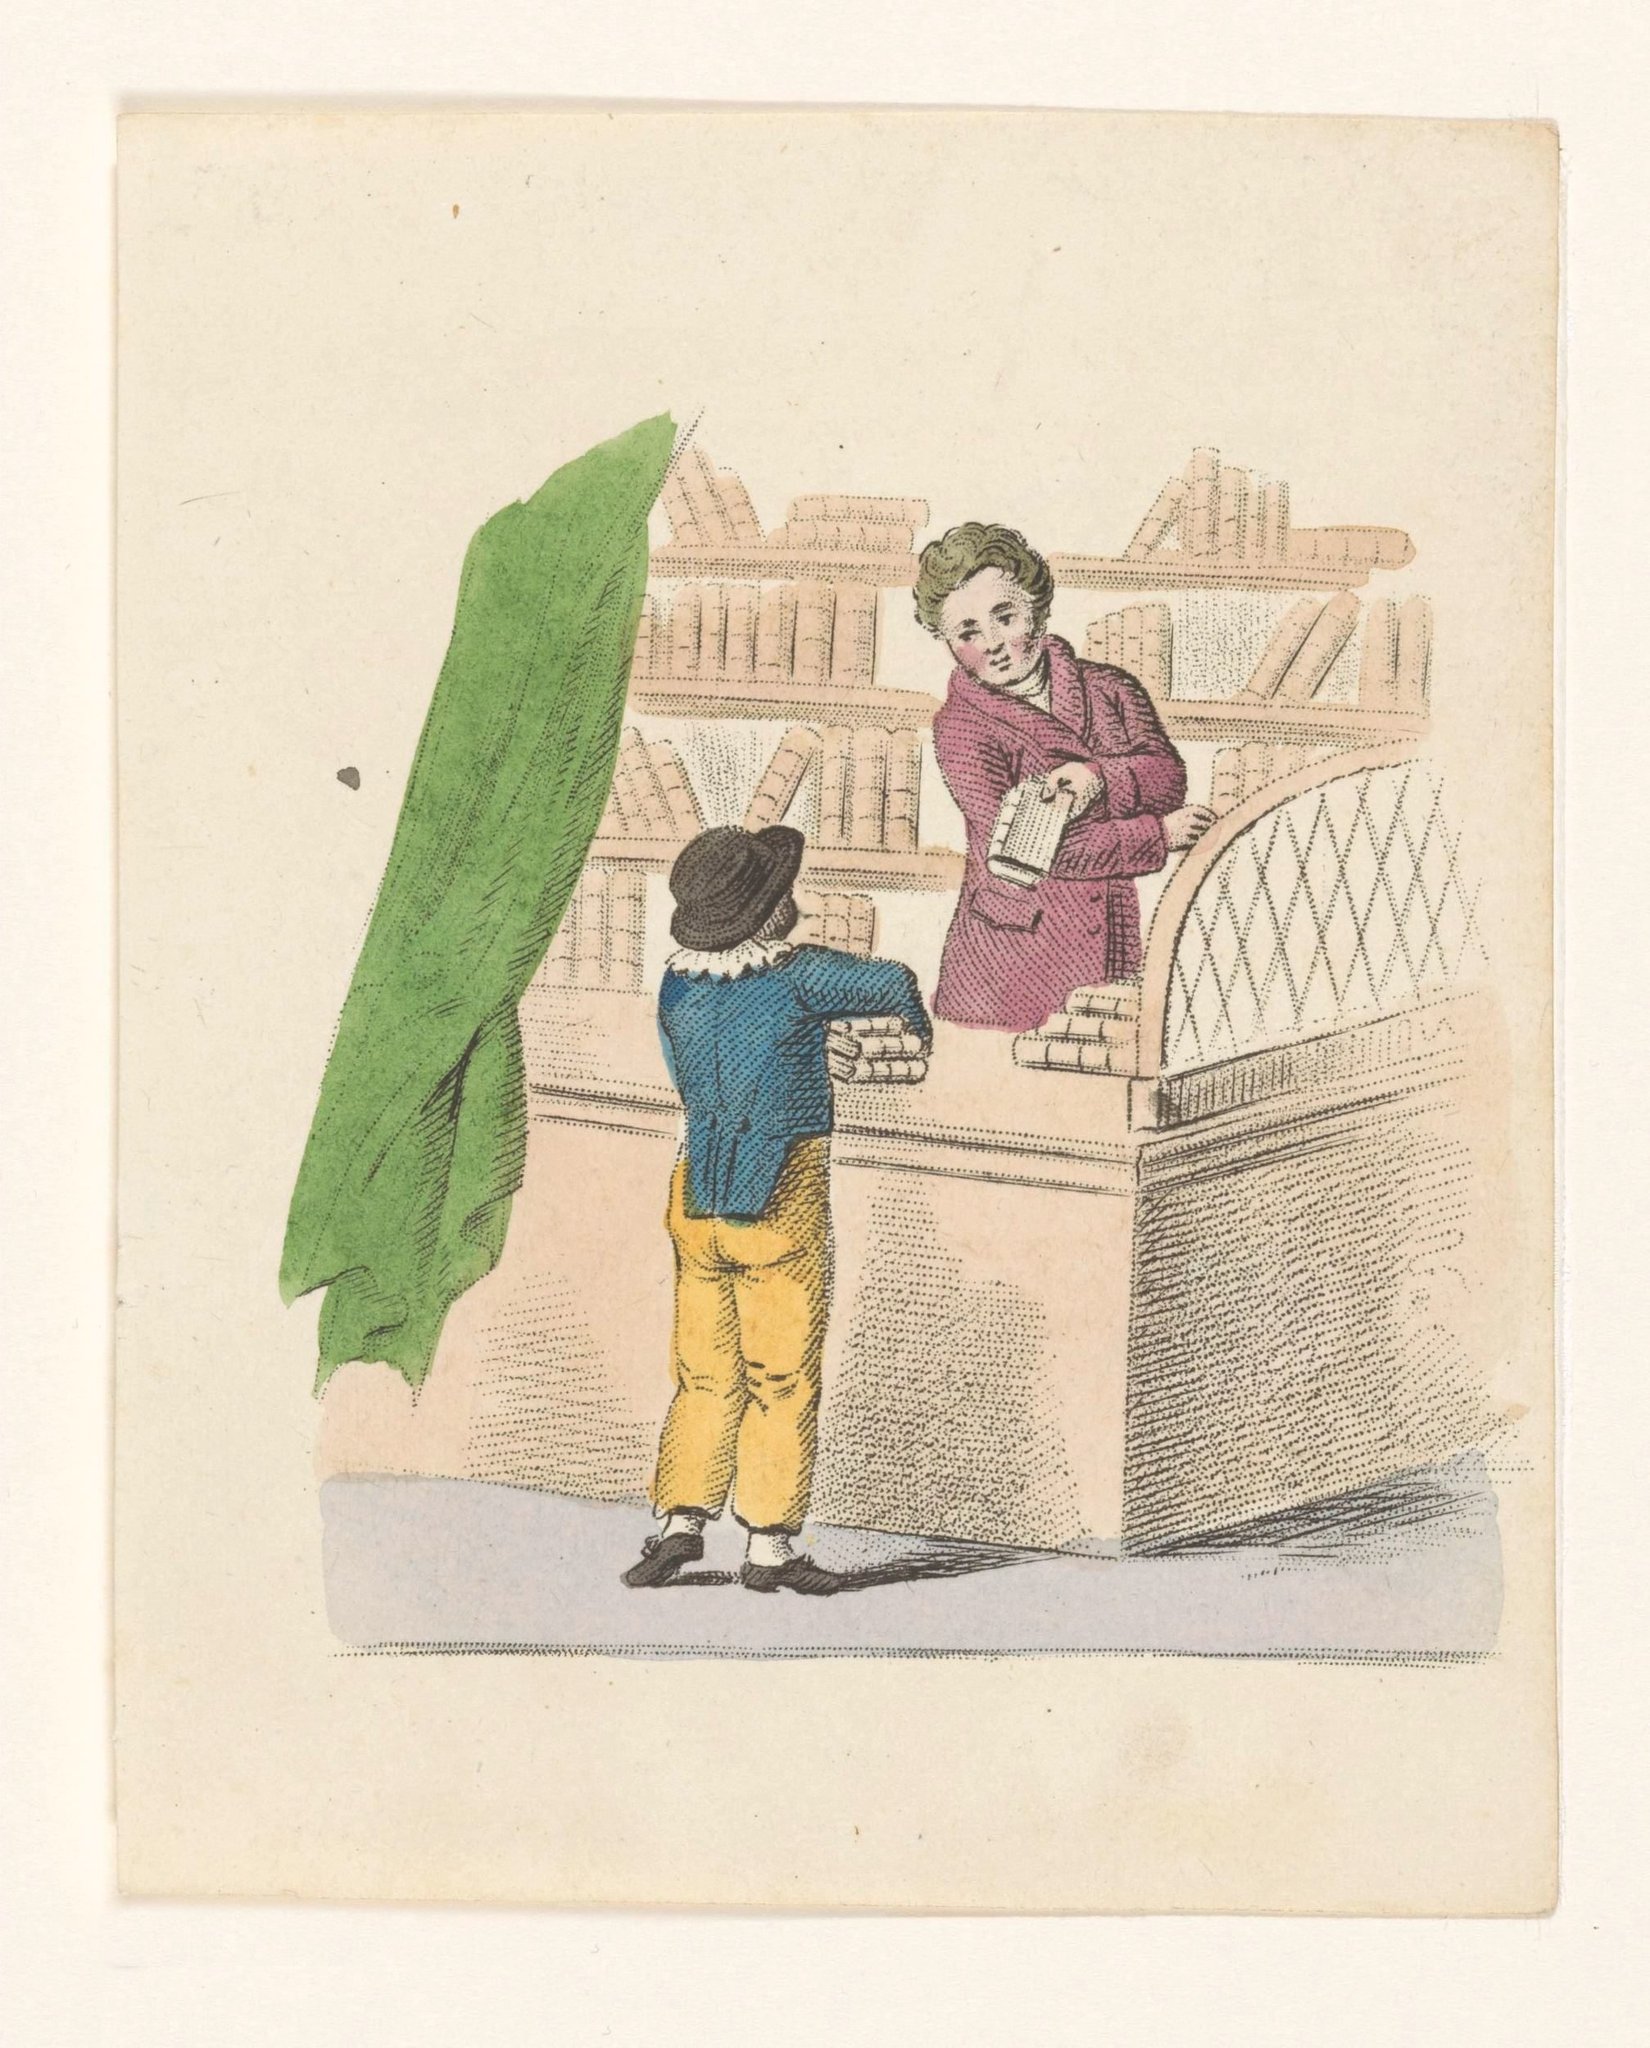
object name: print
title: Jongen in een boekwinkel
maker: Anonymous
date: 1825-1850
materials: paper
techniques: hand coloring, lithograph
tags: book-shop, bookseller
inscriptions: collector's mark: Lugt 2228, collector's mark: Lugt 4780